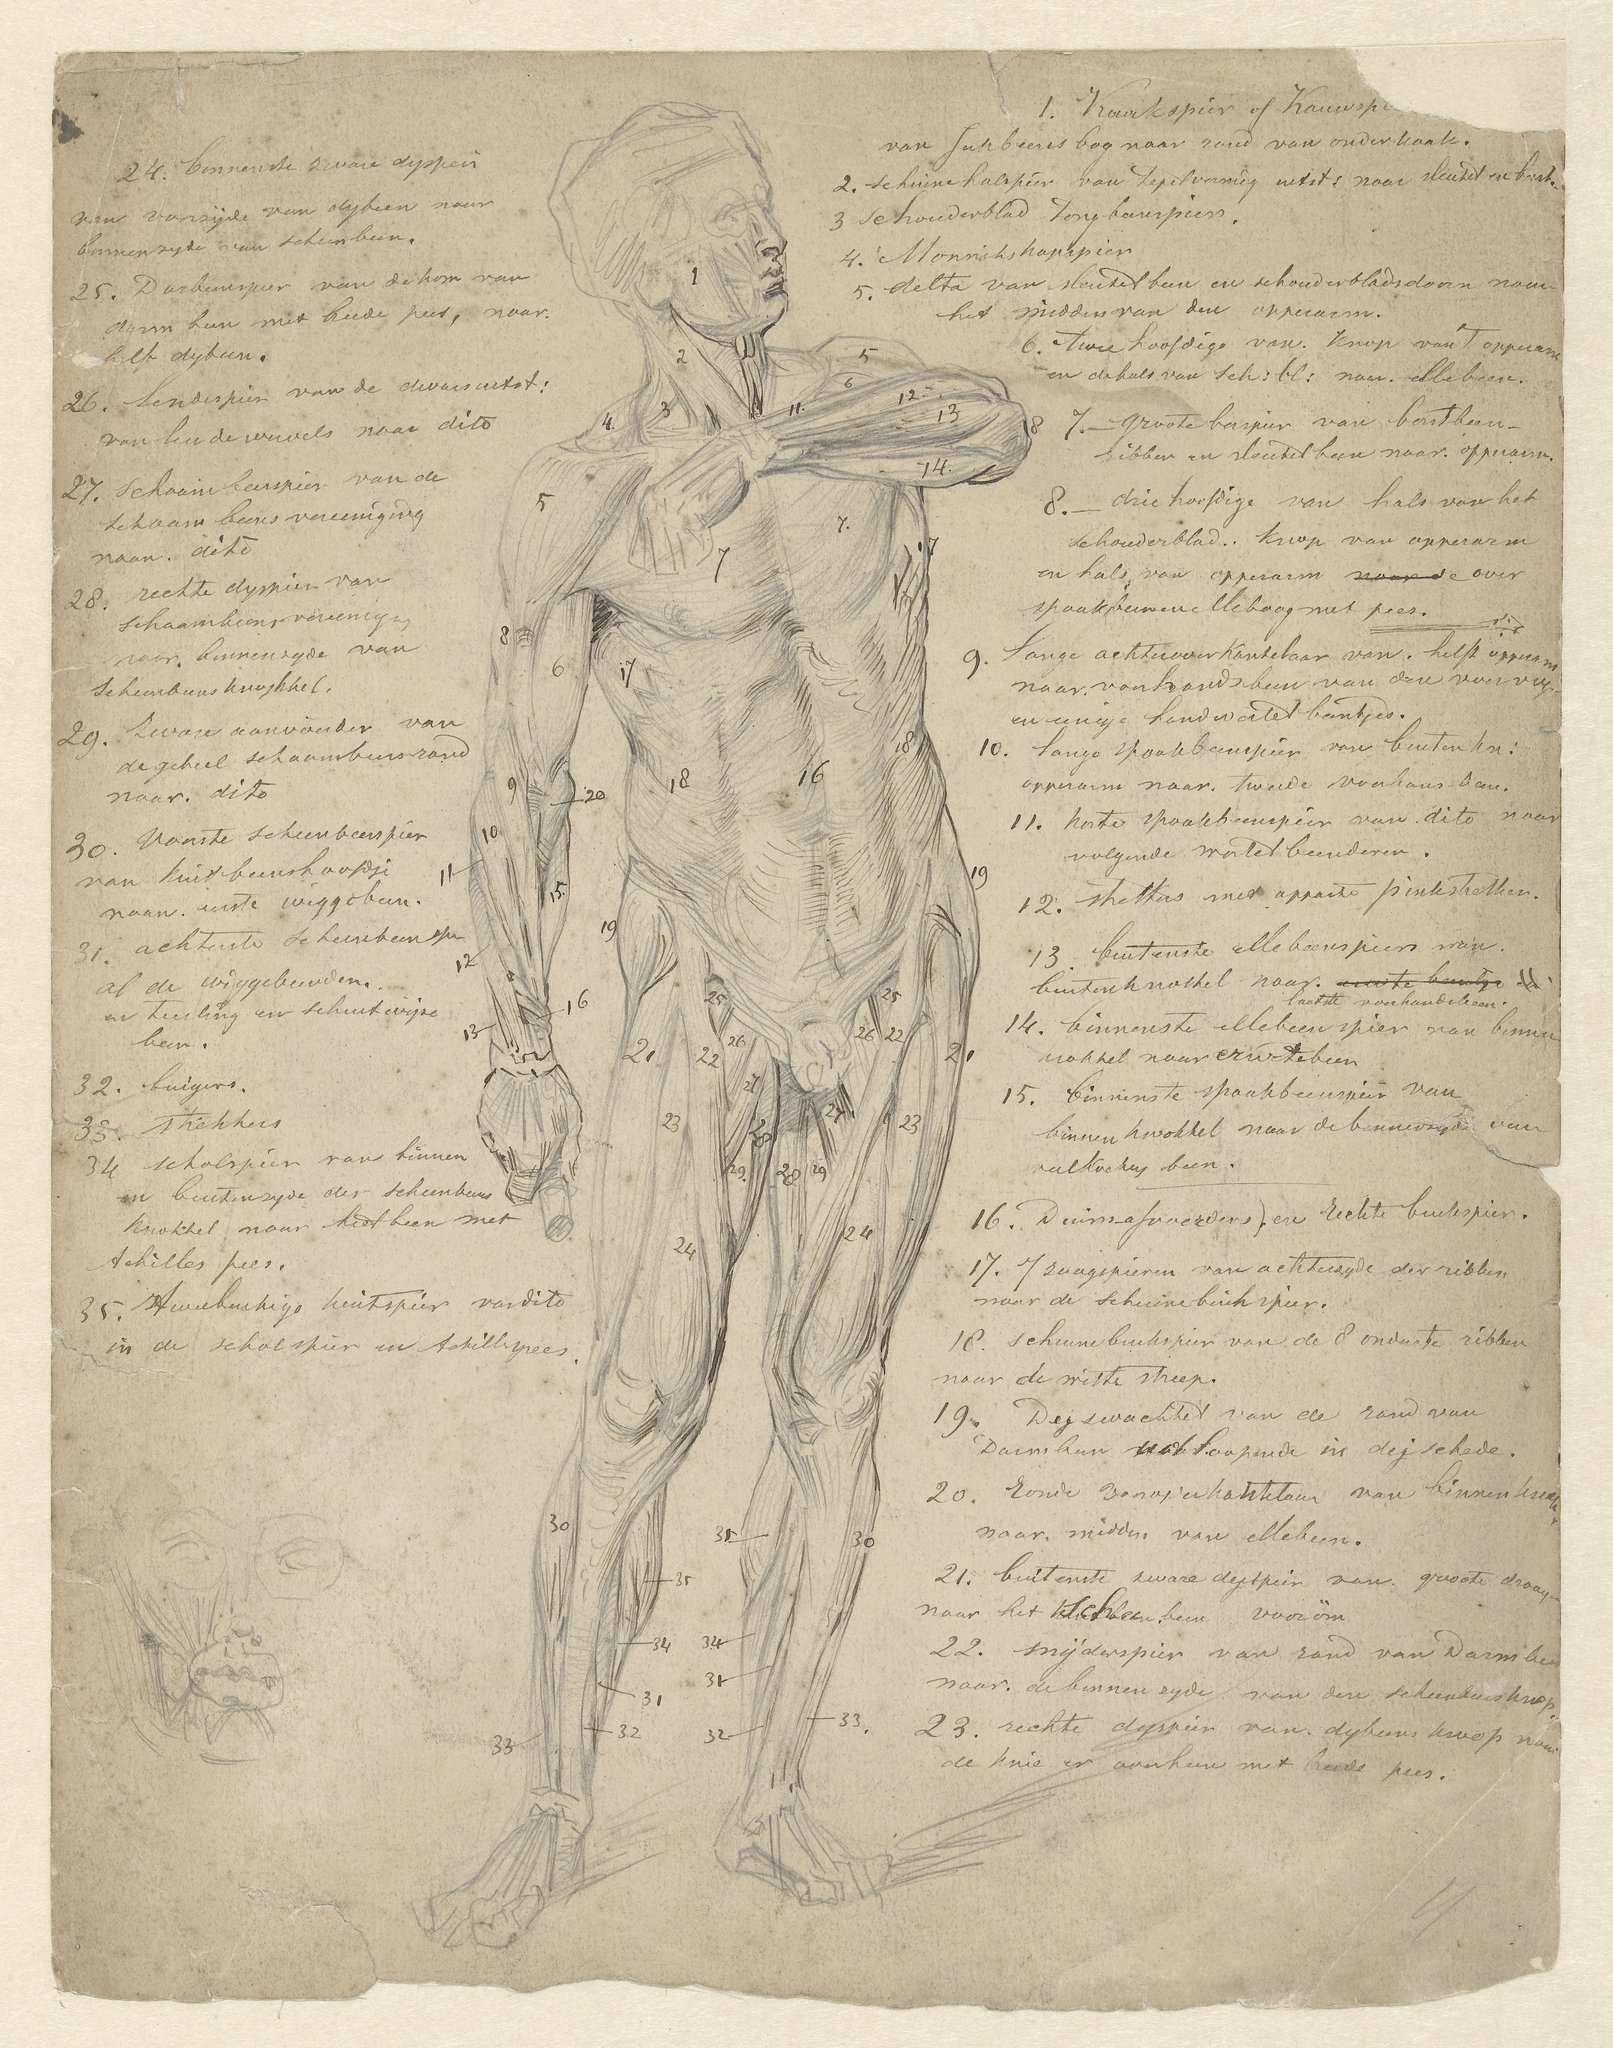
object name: drawing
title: Anatomische studie van staande menselijke figuur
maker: johan braakensiek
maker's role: draughtsman, print maker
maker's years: 1858-1940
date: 1868-1940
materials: ink, paper, pencil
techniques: pen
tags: muscles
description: Anatomische studie van staande menselijke figuur, met aantekeningen; op de verso ook enige detailstudies van spieren.